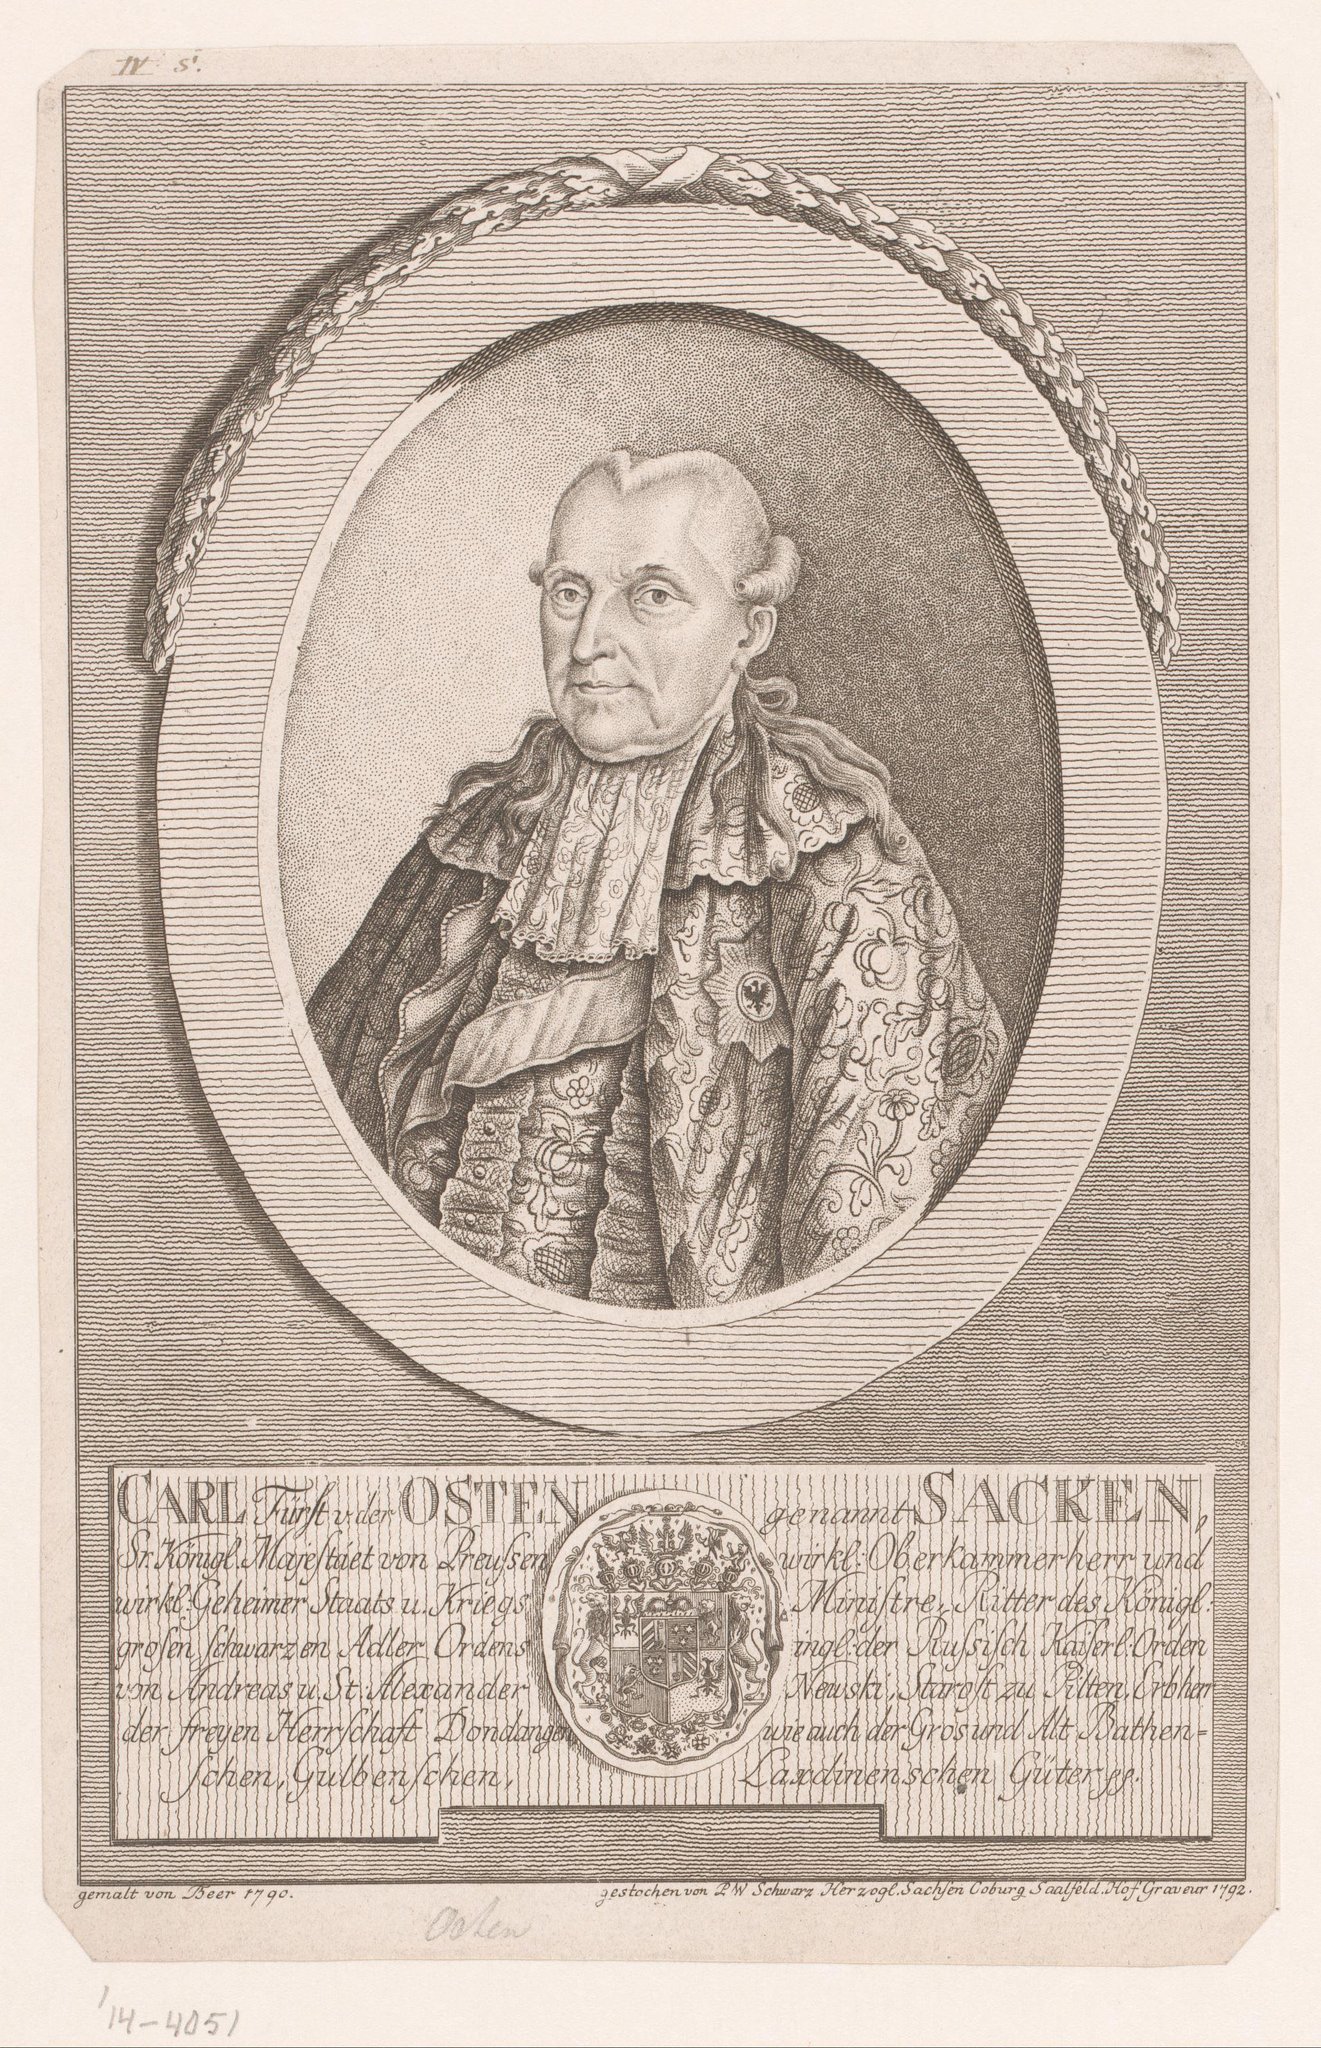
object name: print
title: Portret van Carl von der Osten-Sacken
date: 1792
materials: paper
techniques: etching, engraving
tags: berlin, knighthood order (red eagle order), historical persons, armorial bearing, heraldry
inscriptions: collector's mark: Lugt 2228